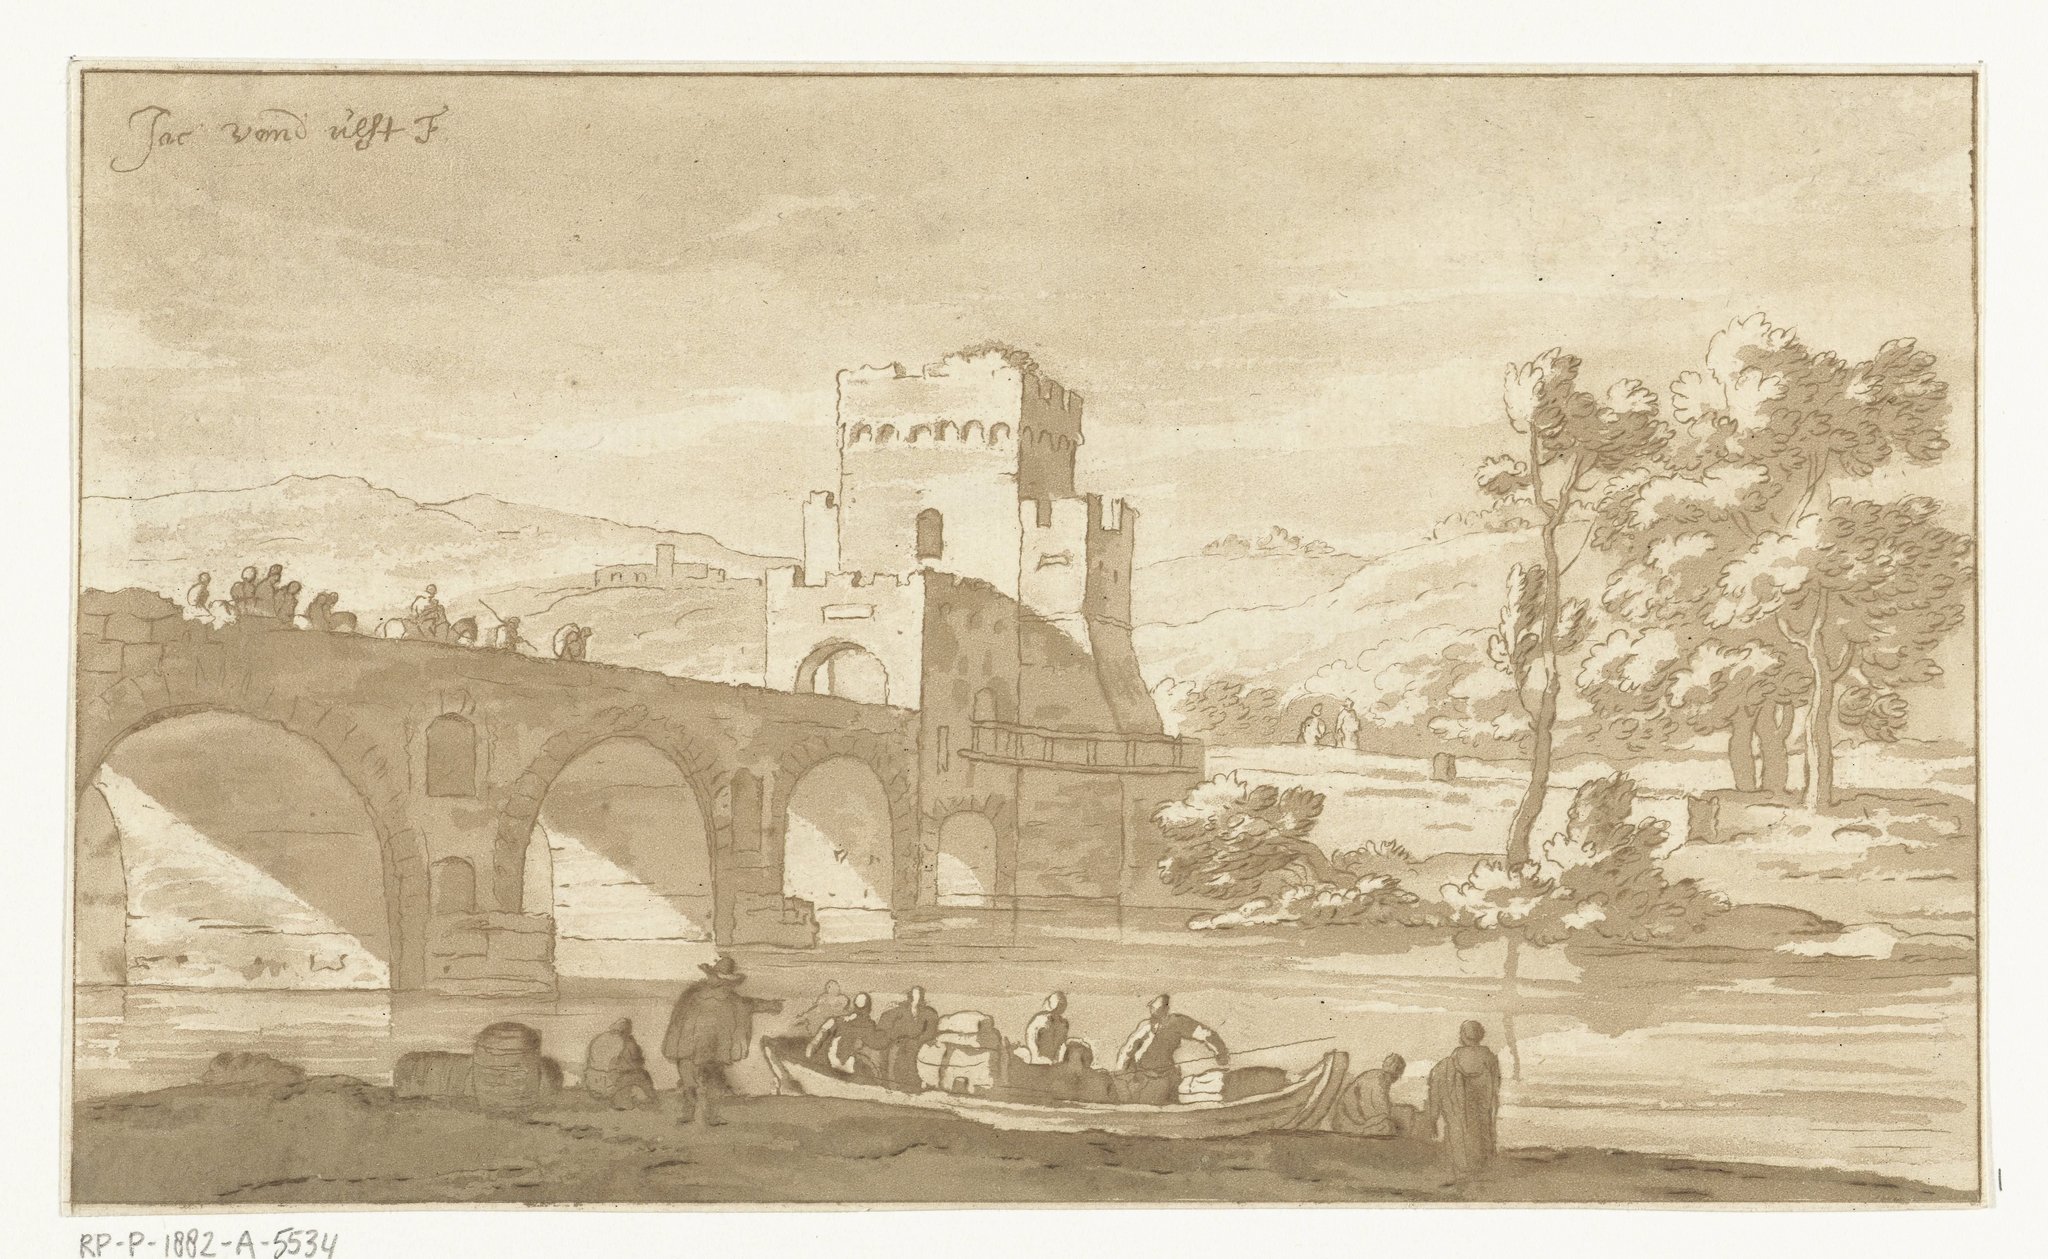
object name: print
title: Ponte Molle bij Rome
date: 1741-1803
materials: paper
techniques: aquatint, etching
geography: netherlands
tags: landscape with bridge, viaduct or aqueduct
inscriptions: collector's mark: Lugt 2228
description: Prent naar tekening van Jacob van der Ulft gedrukt met twee platen. Prent uit serie van negen prenttekeningen met acht landschappen en een zeegezicht naar Hollandse meesters uit de 17e eeuw, zie Huffel 1921, p. 33-35. De originele tekening van Jacob van der Ulft bevindt zich in de collectie van Fondation Custodia te Parijs.